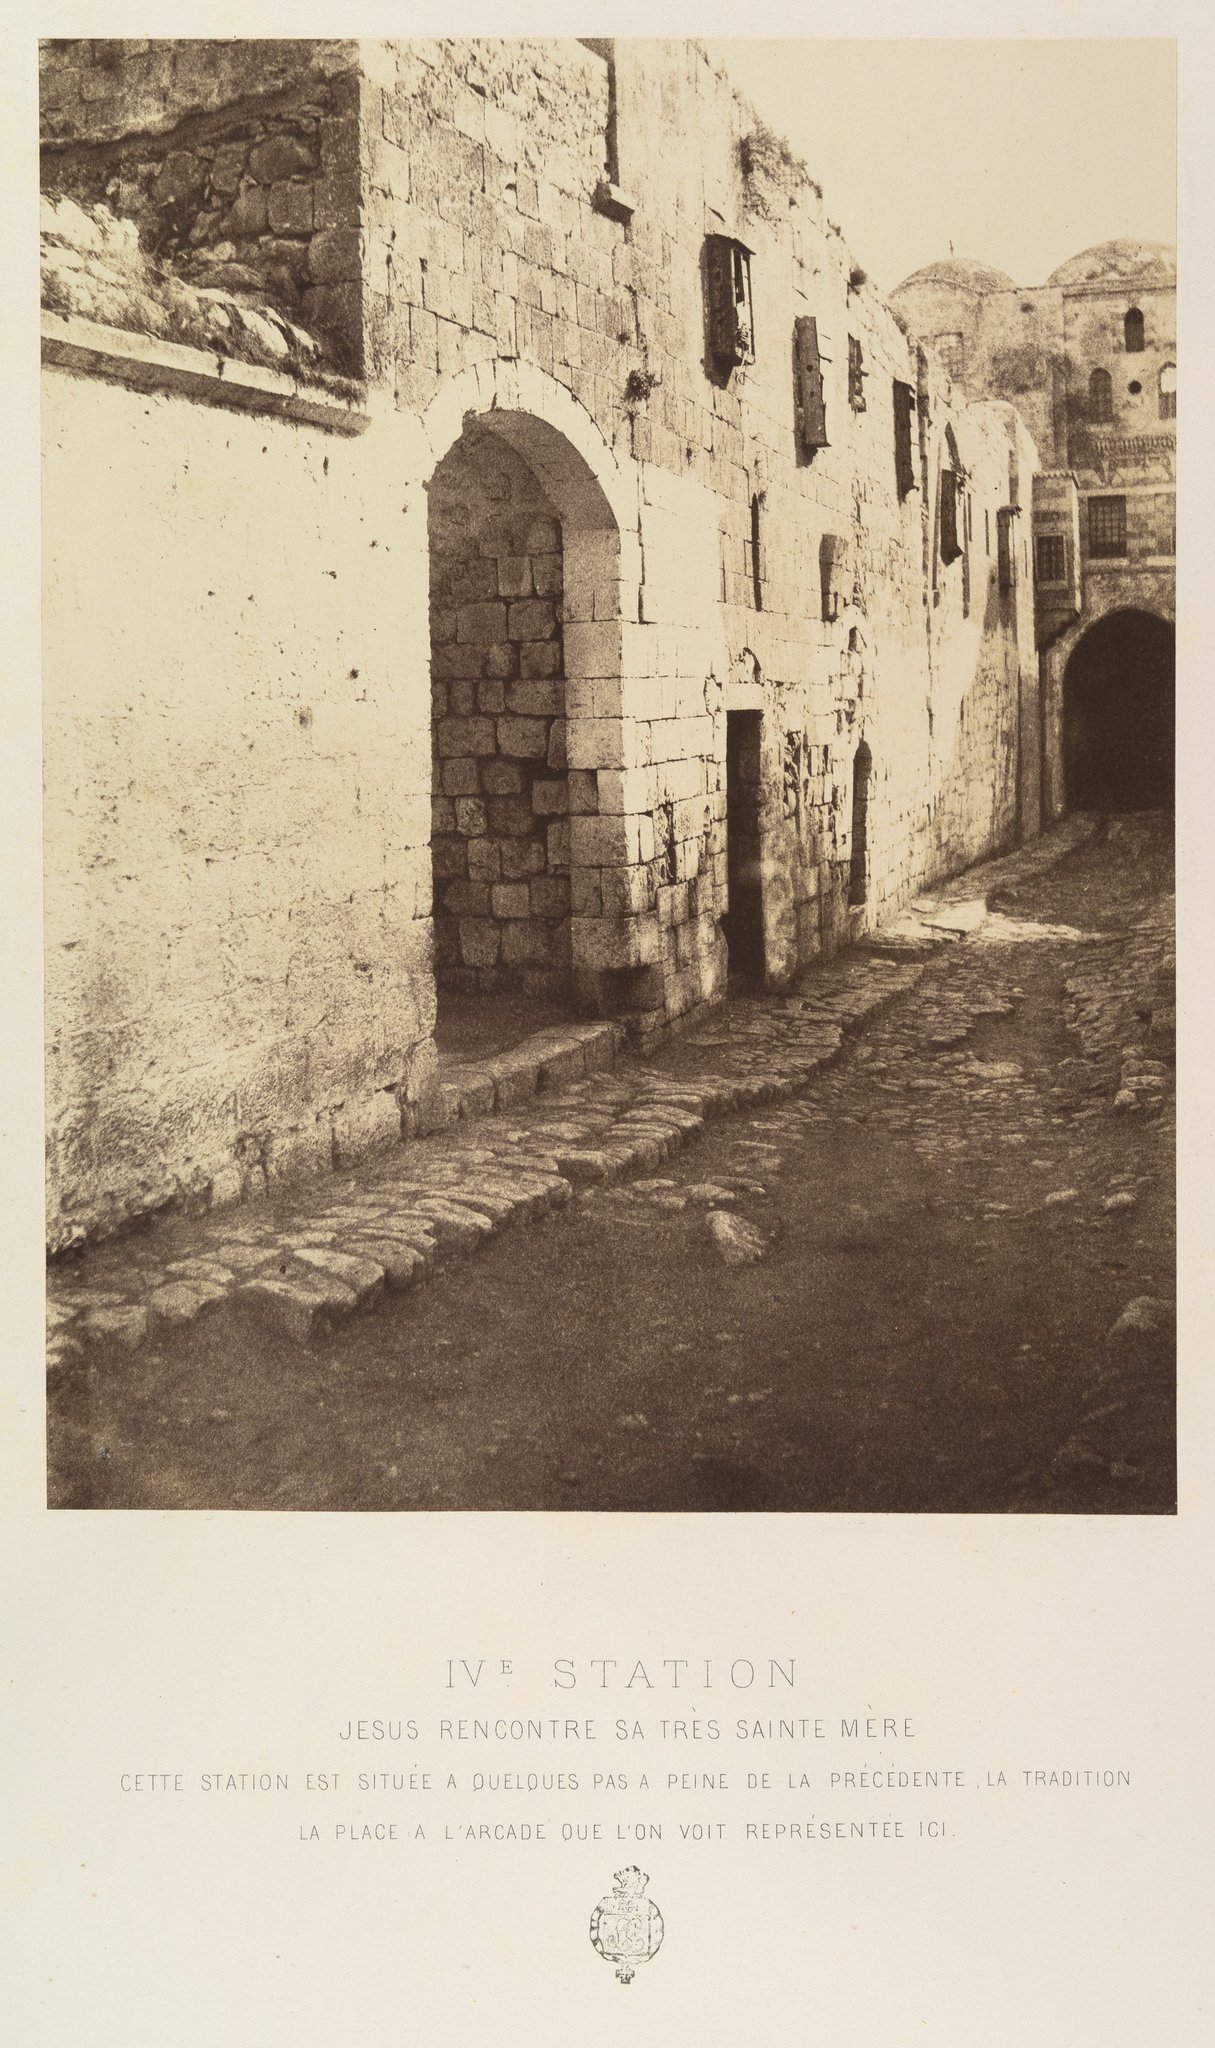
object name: photograph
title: IVe Station. Jésus rencontre sa très Sainte Mère. Cette station est située a quelques pas a peine de la précédente. La tradition la place a l'arcade que l'on voit représentée ici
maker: louis de clercq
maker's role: artist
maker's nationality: french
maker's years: 1837-1901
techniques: albumen silver print, paper negative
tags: arches,buildings